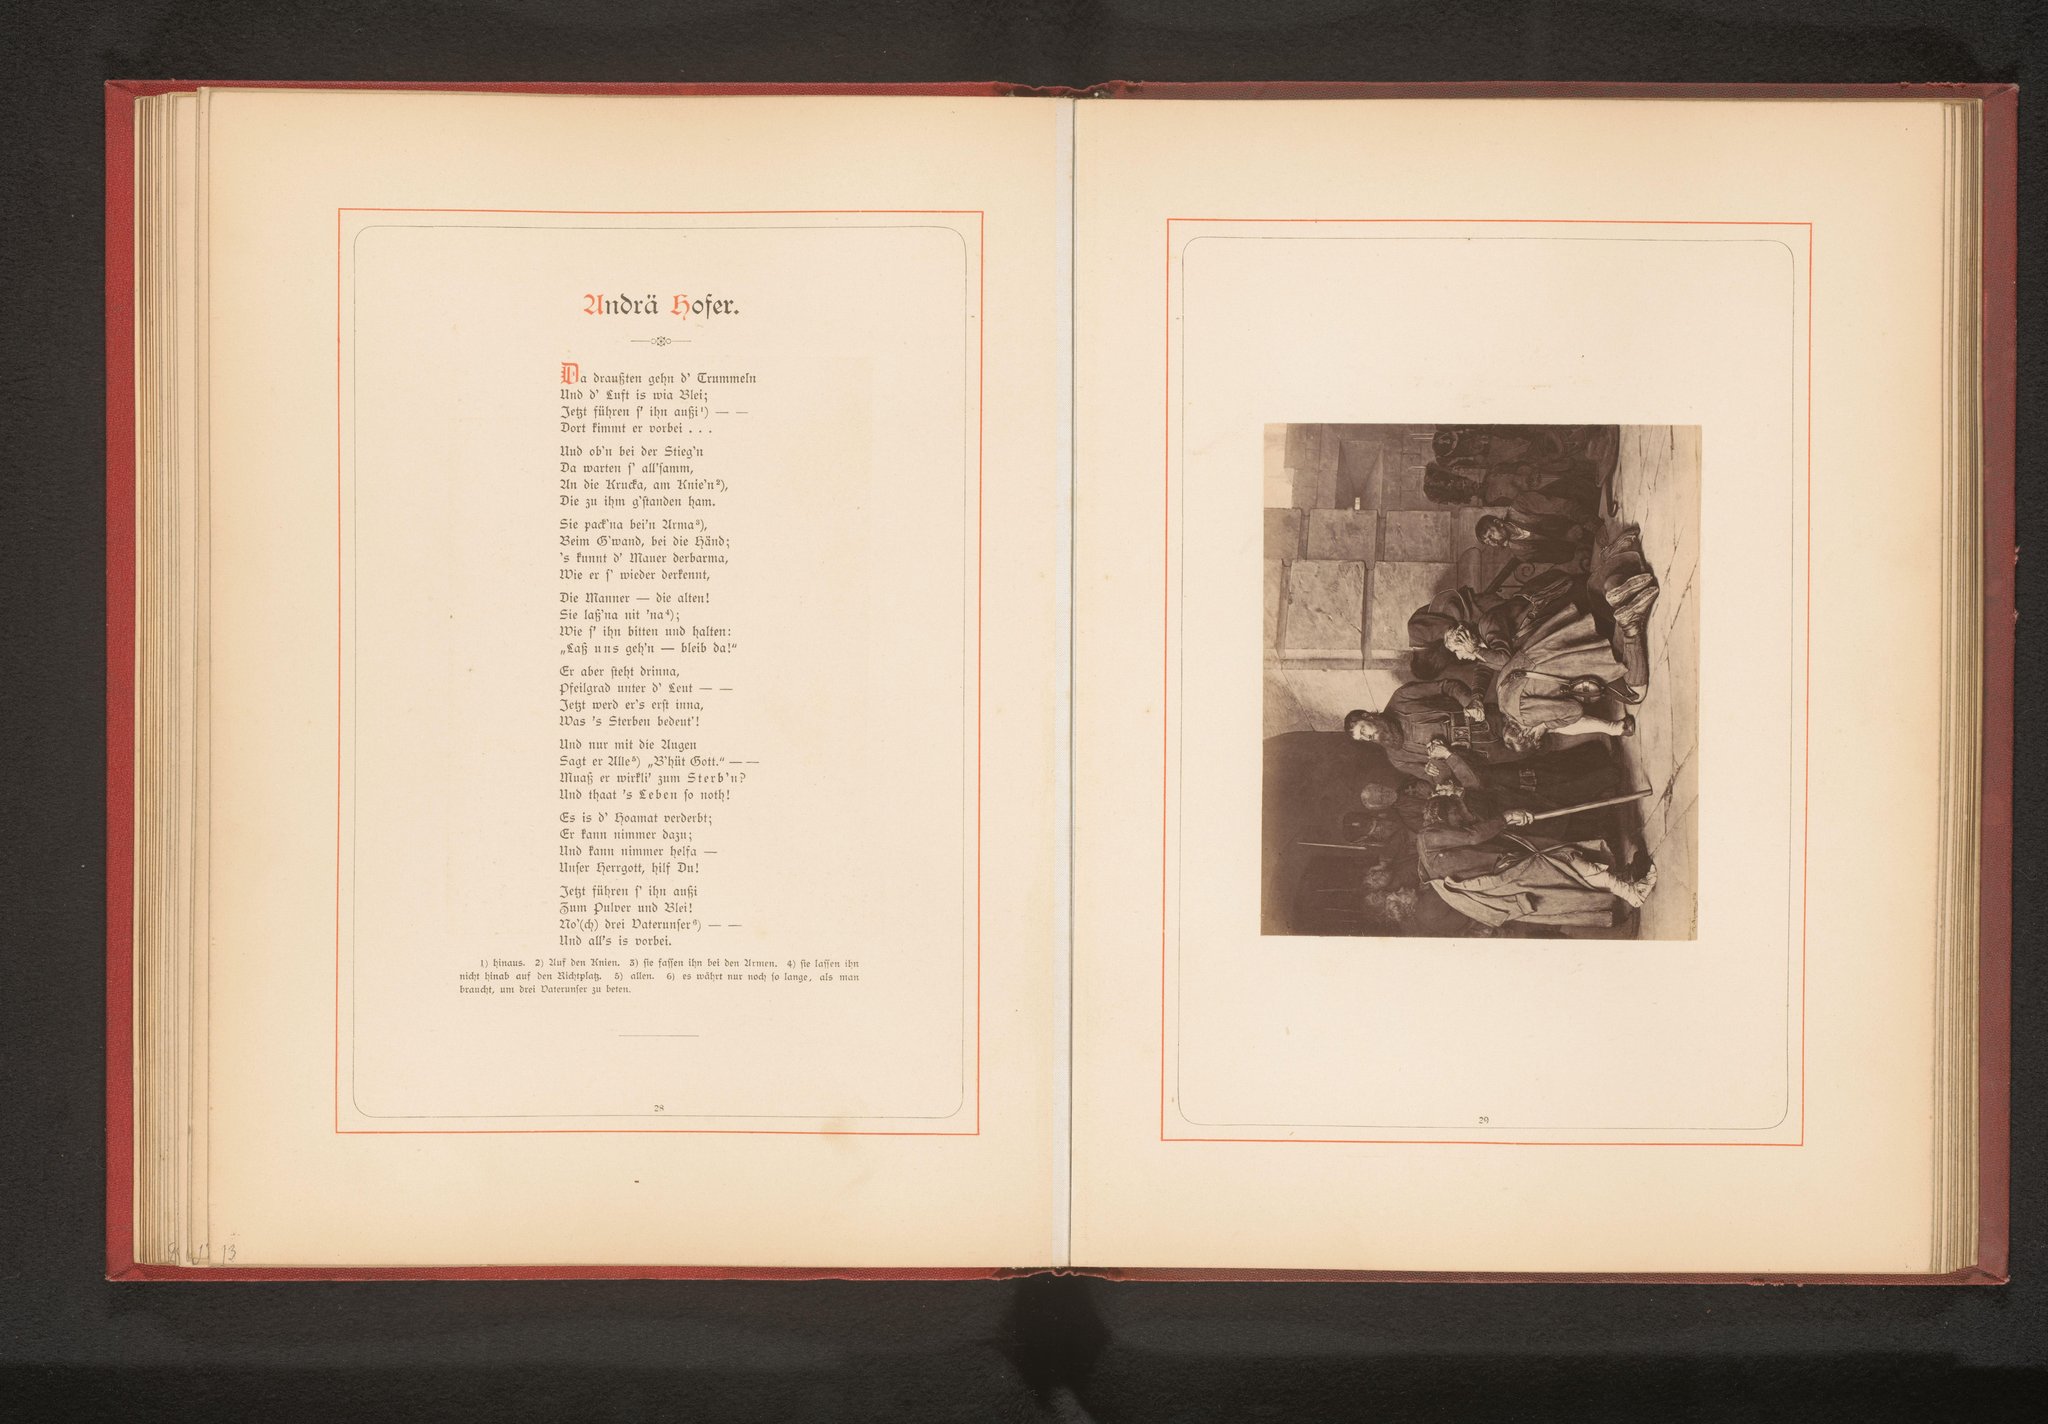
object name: page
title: Fotoreproductie van een schilderij, voorstellende smekende mannen (vermoedelijk) bij een belegering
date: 1878-1885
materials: photographic support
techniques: albumen print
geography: germany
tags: despair (of person under sentence of death), siege